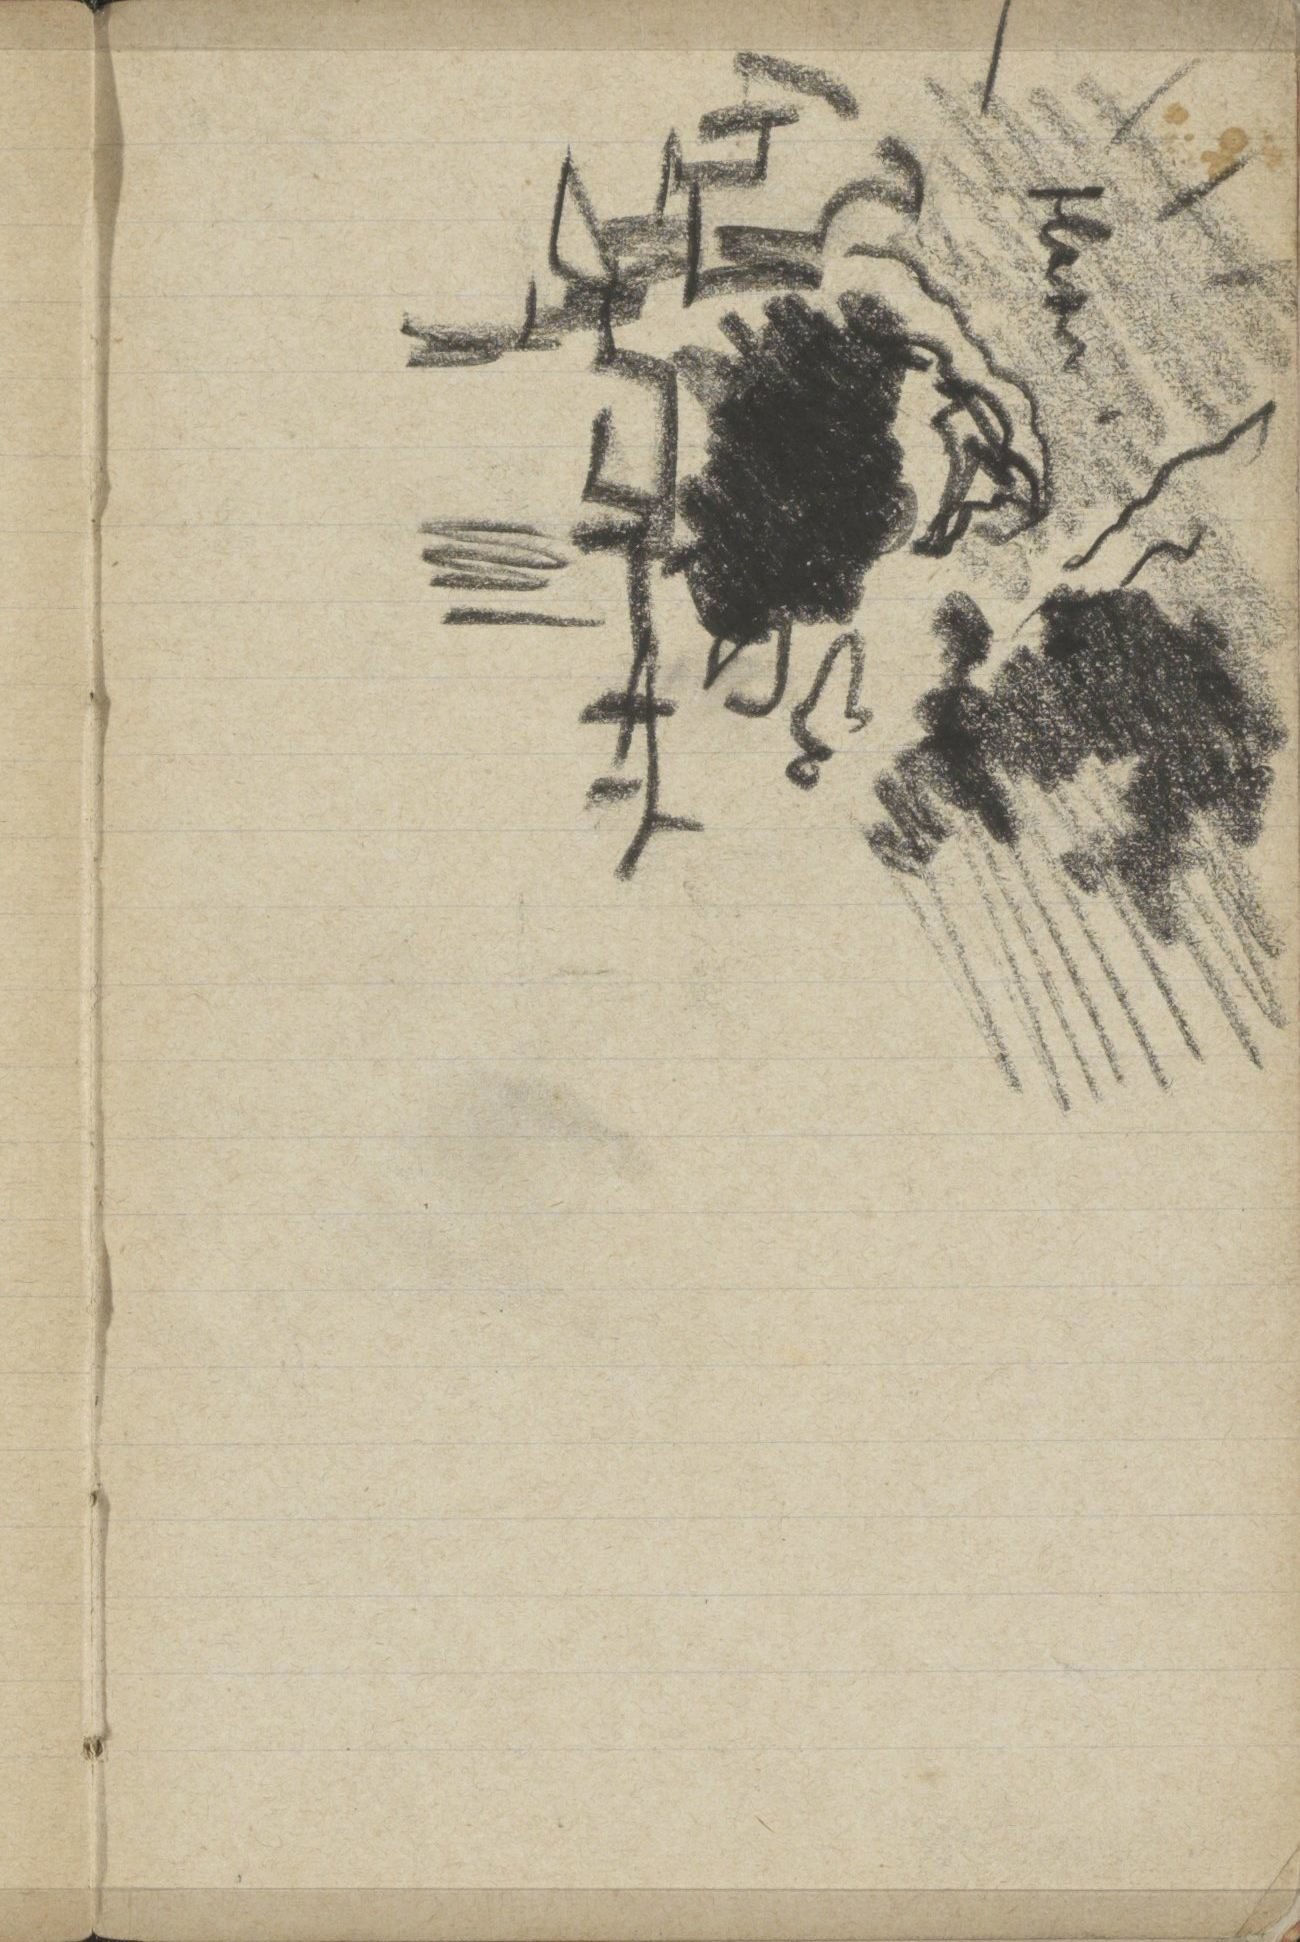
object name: sketchbook leaf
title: Wolkenlucht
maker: george hendrik breitner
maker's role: draughtsman, painter, print maker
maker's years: 1857-1923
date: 1886-1903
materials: chalk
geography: amsterdam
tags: clouds, civic architecture; edifices; dwellings, amsterdam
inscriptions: kleurnotitie, handgeschreven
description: Pagina 74 uit een schetsboek met 41 bladen.